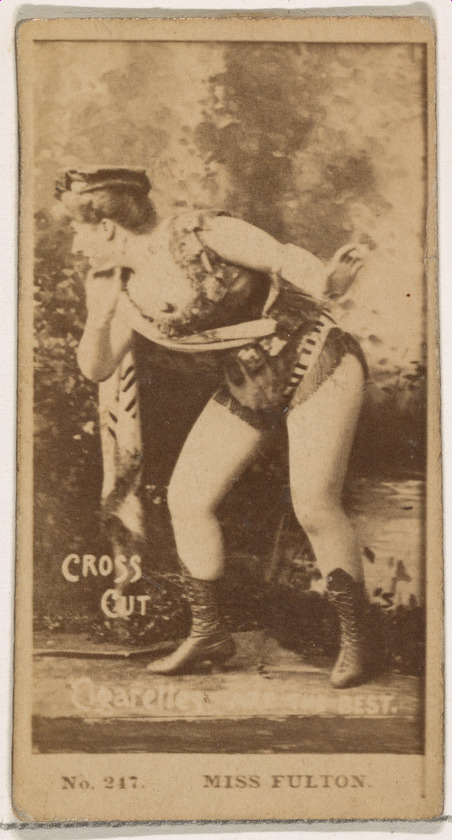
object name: print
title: Card Number 247, Miss Fulton, from the Actors and Actresses series (N145-2) issued by Duke Sons & Co. to promote Cross Cut Cigarettes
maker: w. duke, sons & co.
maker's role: publisher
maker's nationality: american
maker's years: 1870-1920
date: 1880-1889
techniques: albumen silver print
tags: women,actresses